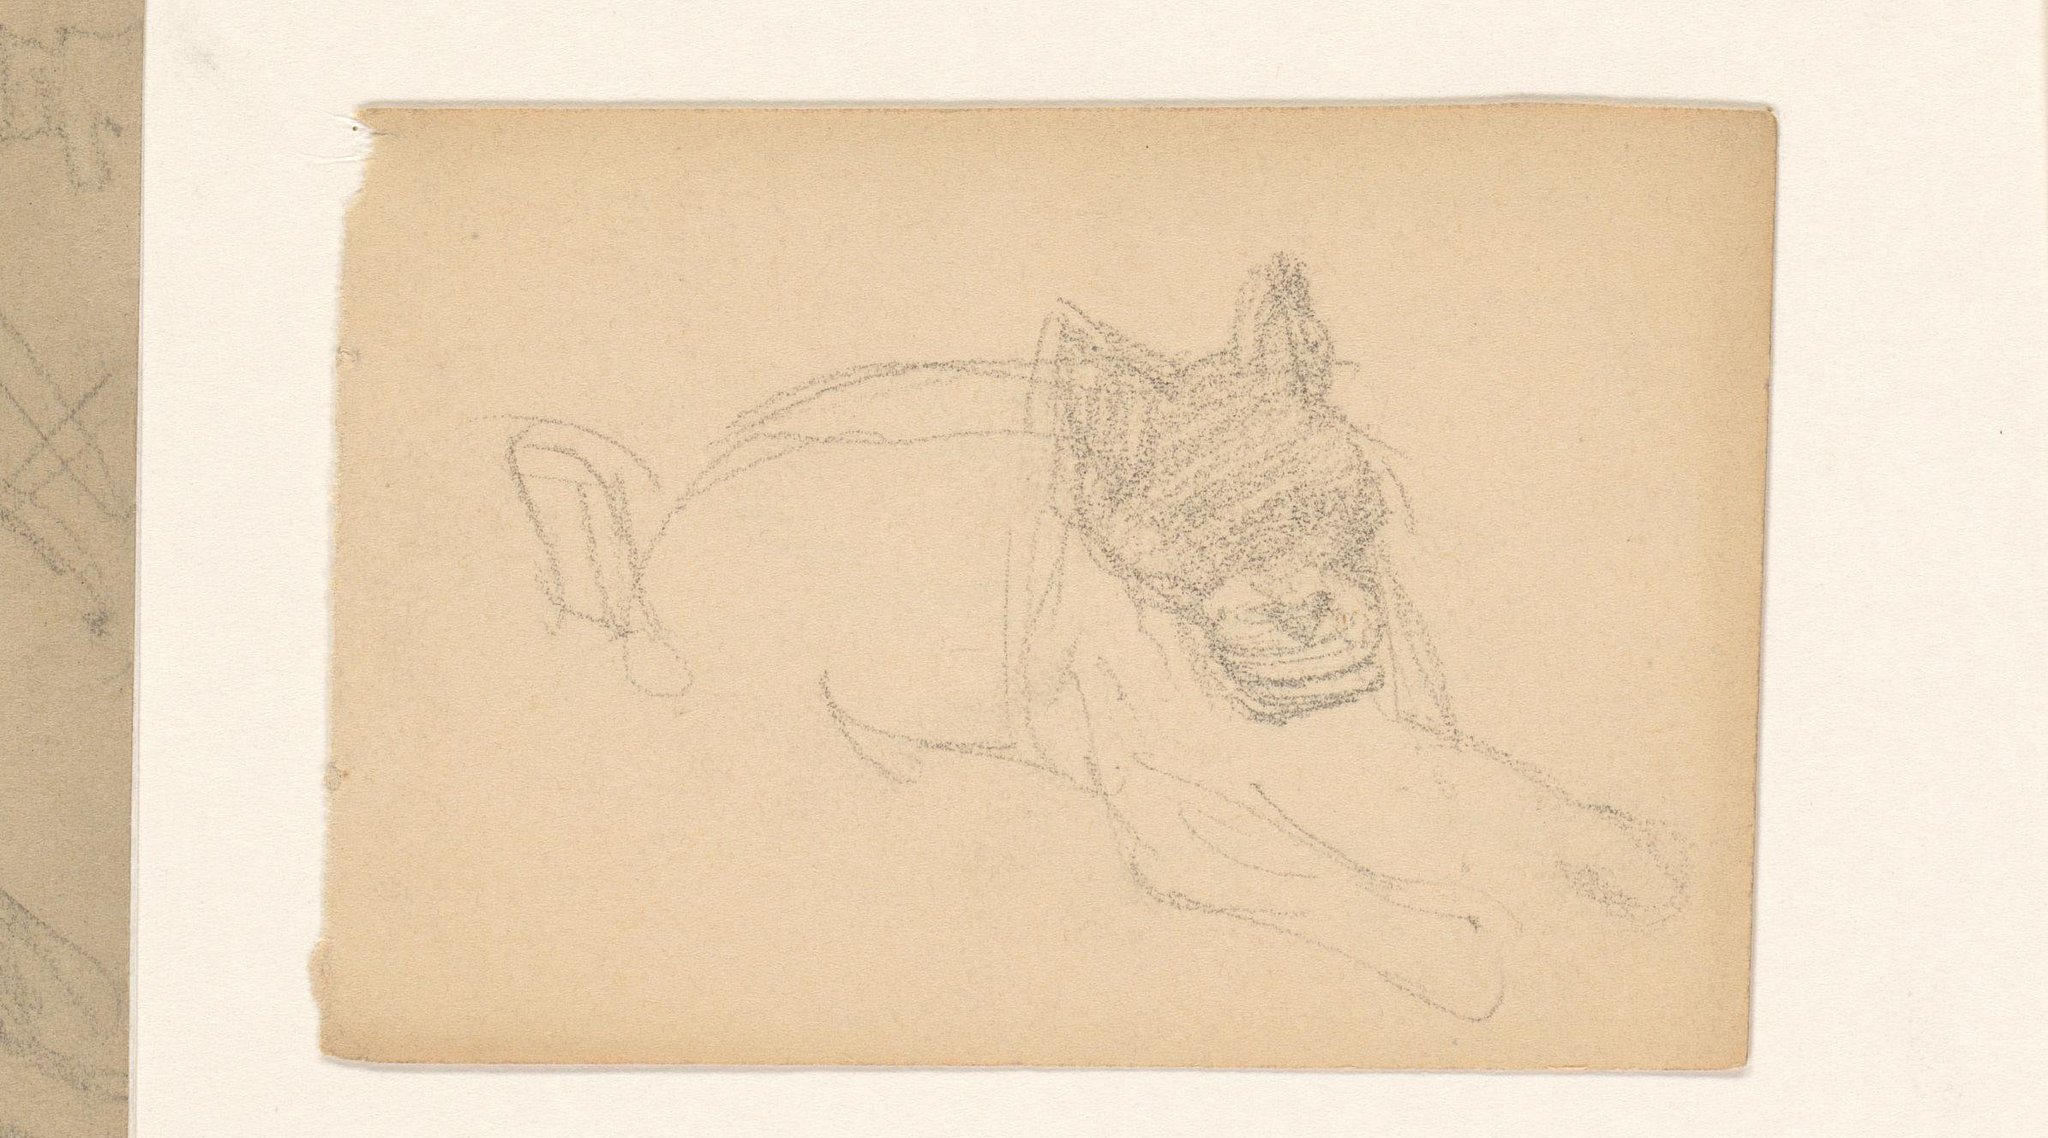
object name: drawing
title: De mislukte hond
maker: august allebé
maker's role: draughtsman, print maker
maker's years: 1838-1927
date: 1848-1927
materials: paper, pencil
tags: dog